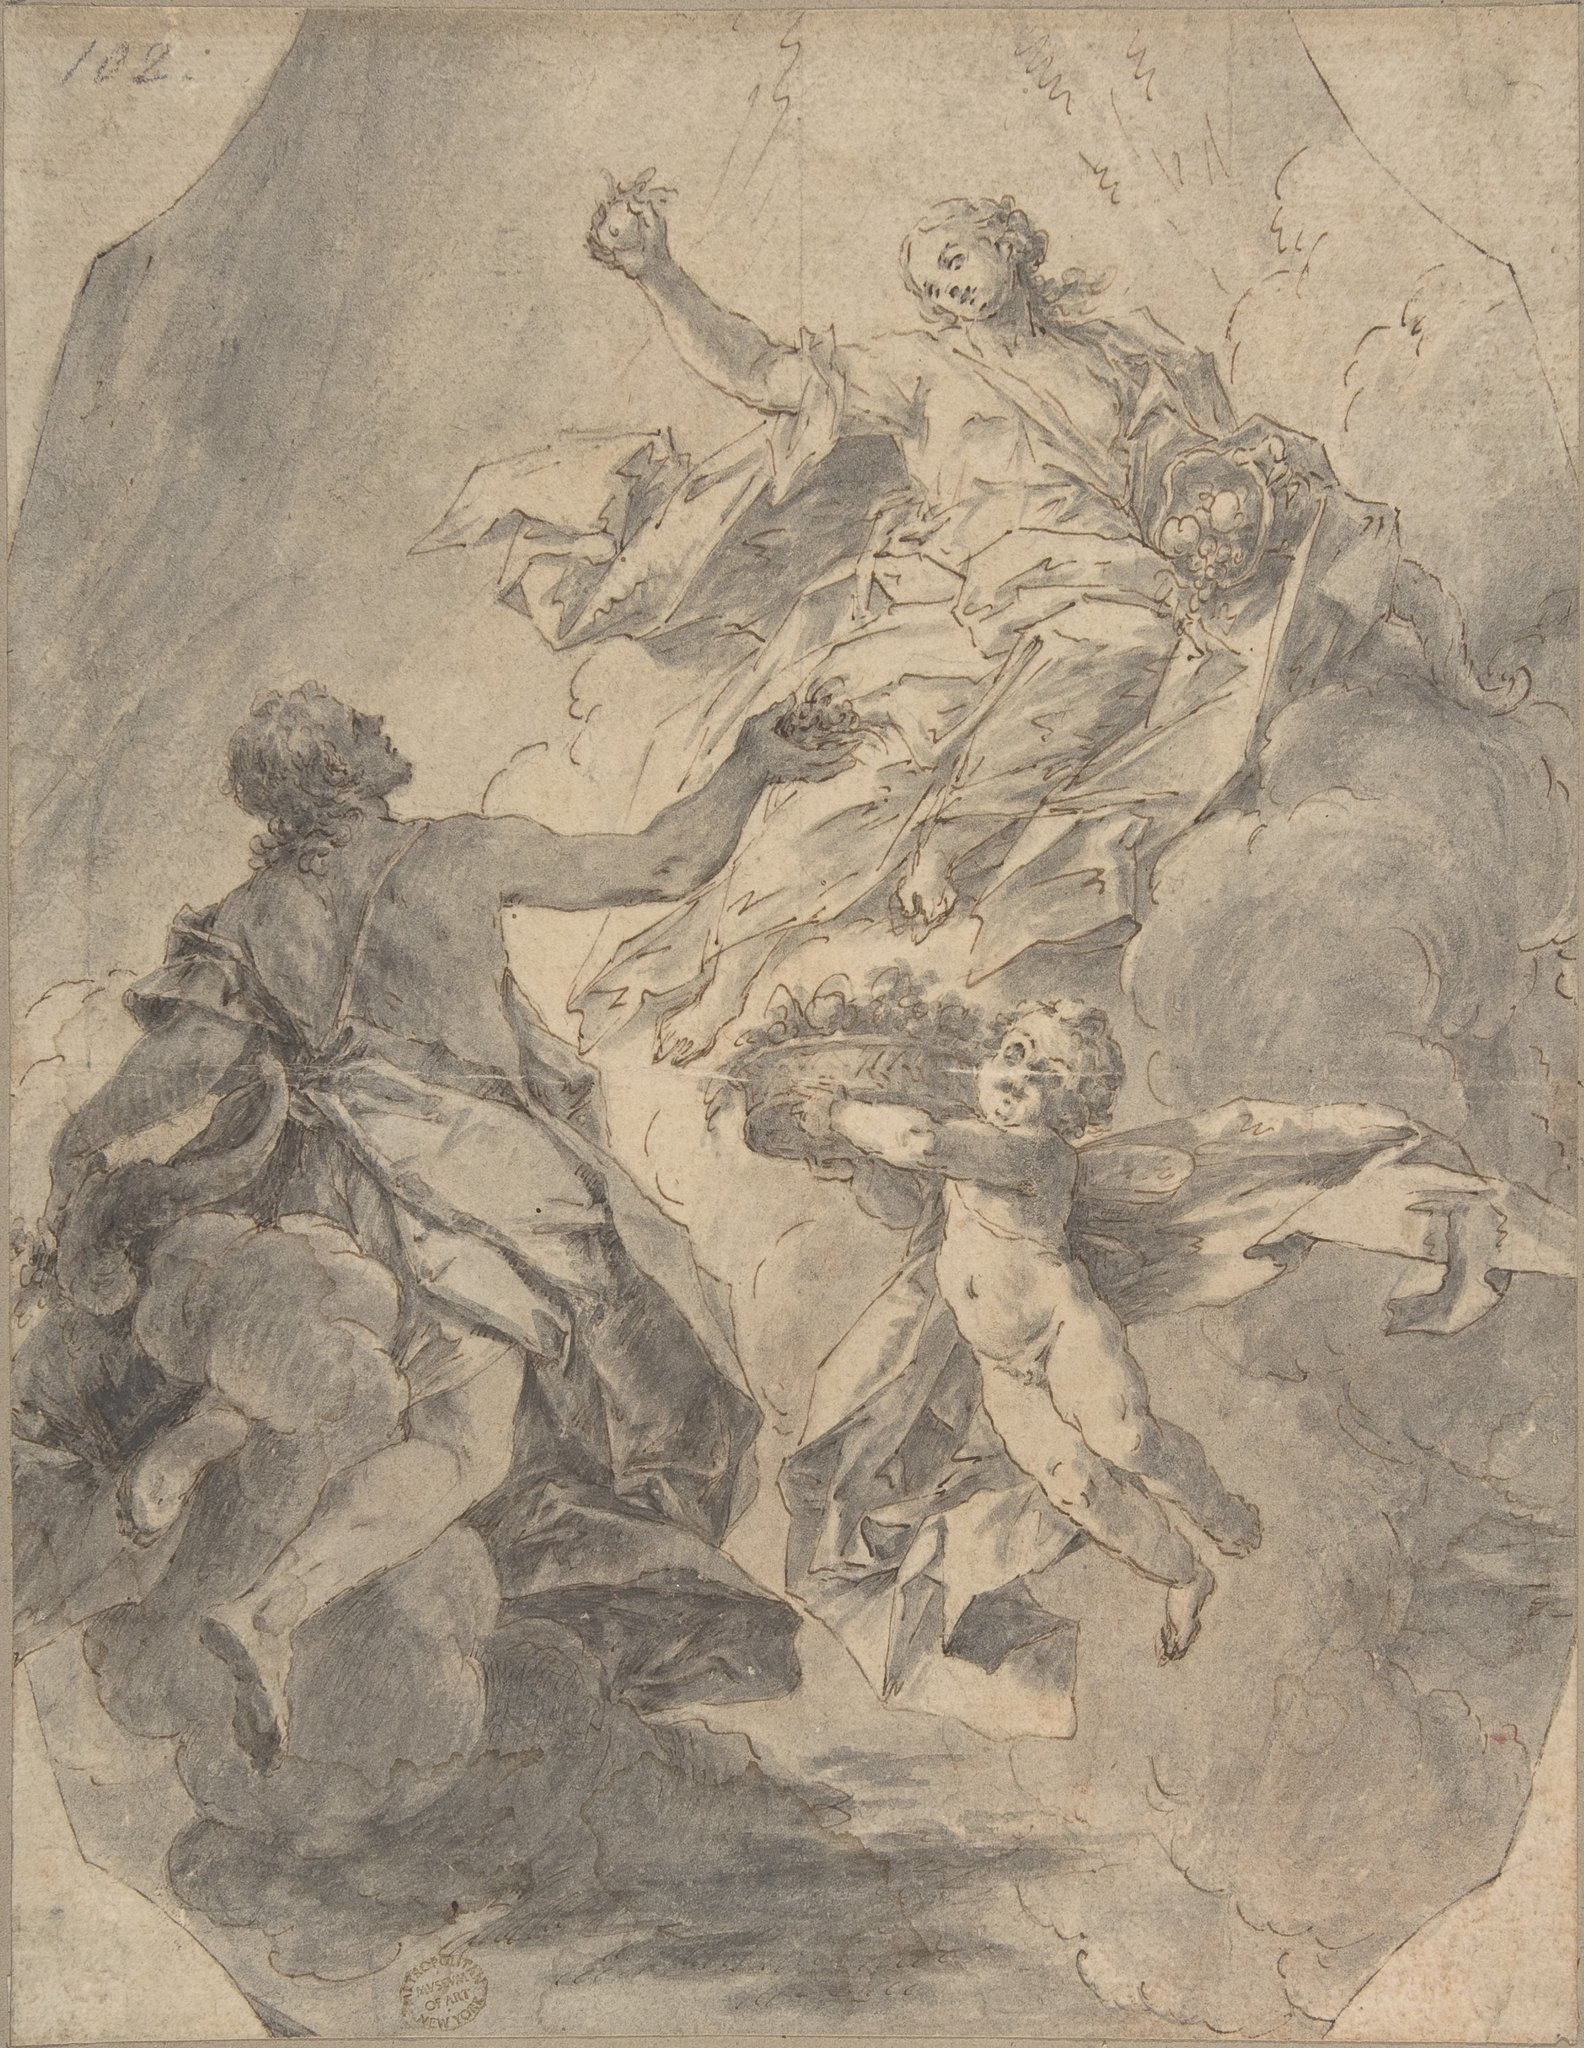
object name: drawing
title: Allegory of Abundance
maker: anonymous, french, 17th century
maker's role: artist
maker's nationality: french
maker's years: 1600-1700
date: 1601-1700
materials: ink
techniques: brush, pen, wash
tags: men,women,putti